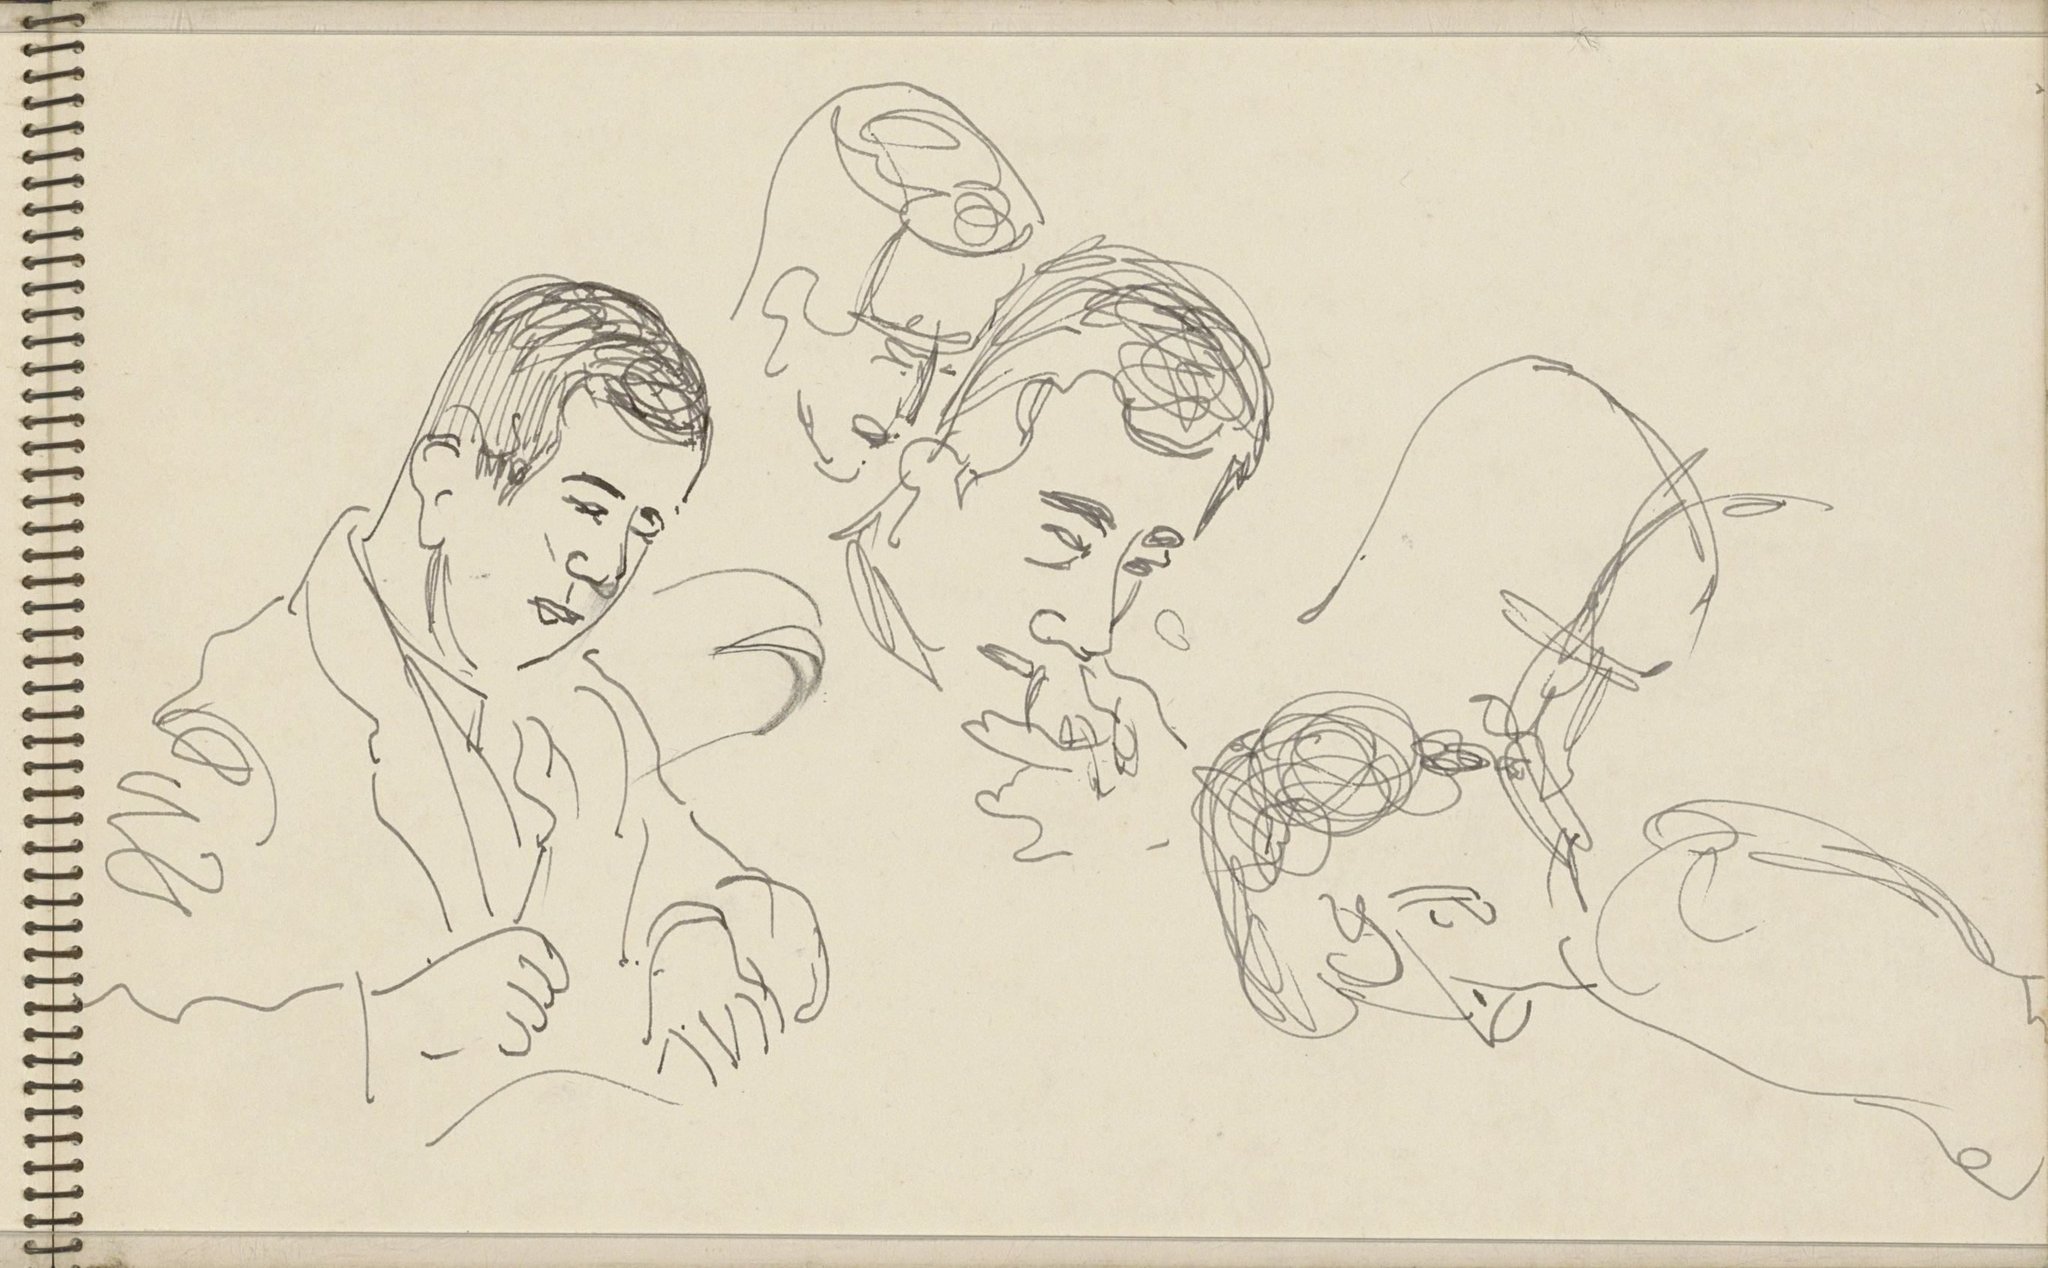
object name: sketchbook leaf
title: Mannenkoppen en een schrijvende man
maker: carel adolph lion cachet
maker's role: draughtsman, print maker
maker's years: 1864-1945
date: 1930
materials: ink, paper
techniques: pen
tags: handwriting, writing as activity, head (human)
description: Blad 3 recto uit een schetsboek met 14 bladen.